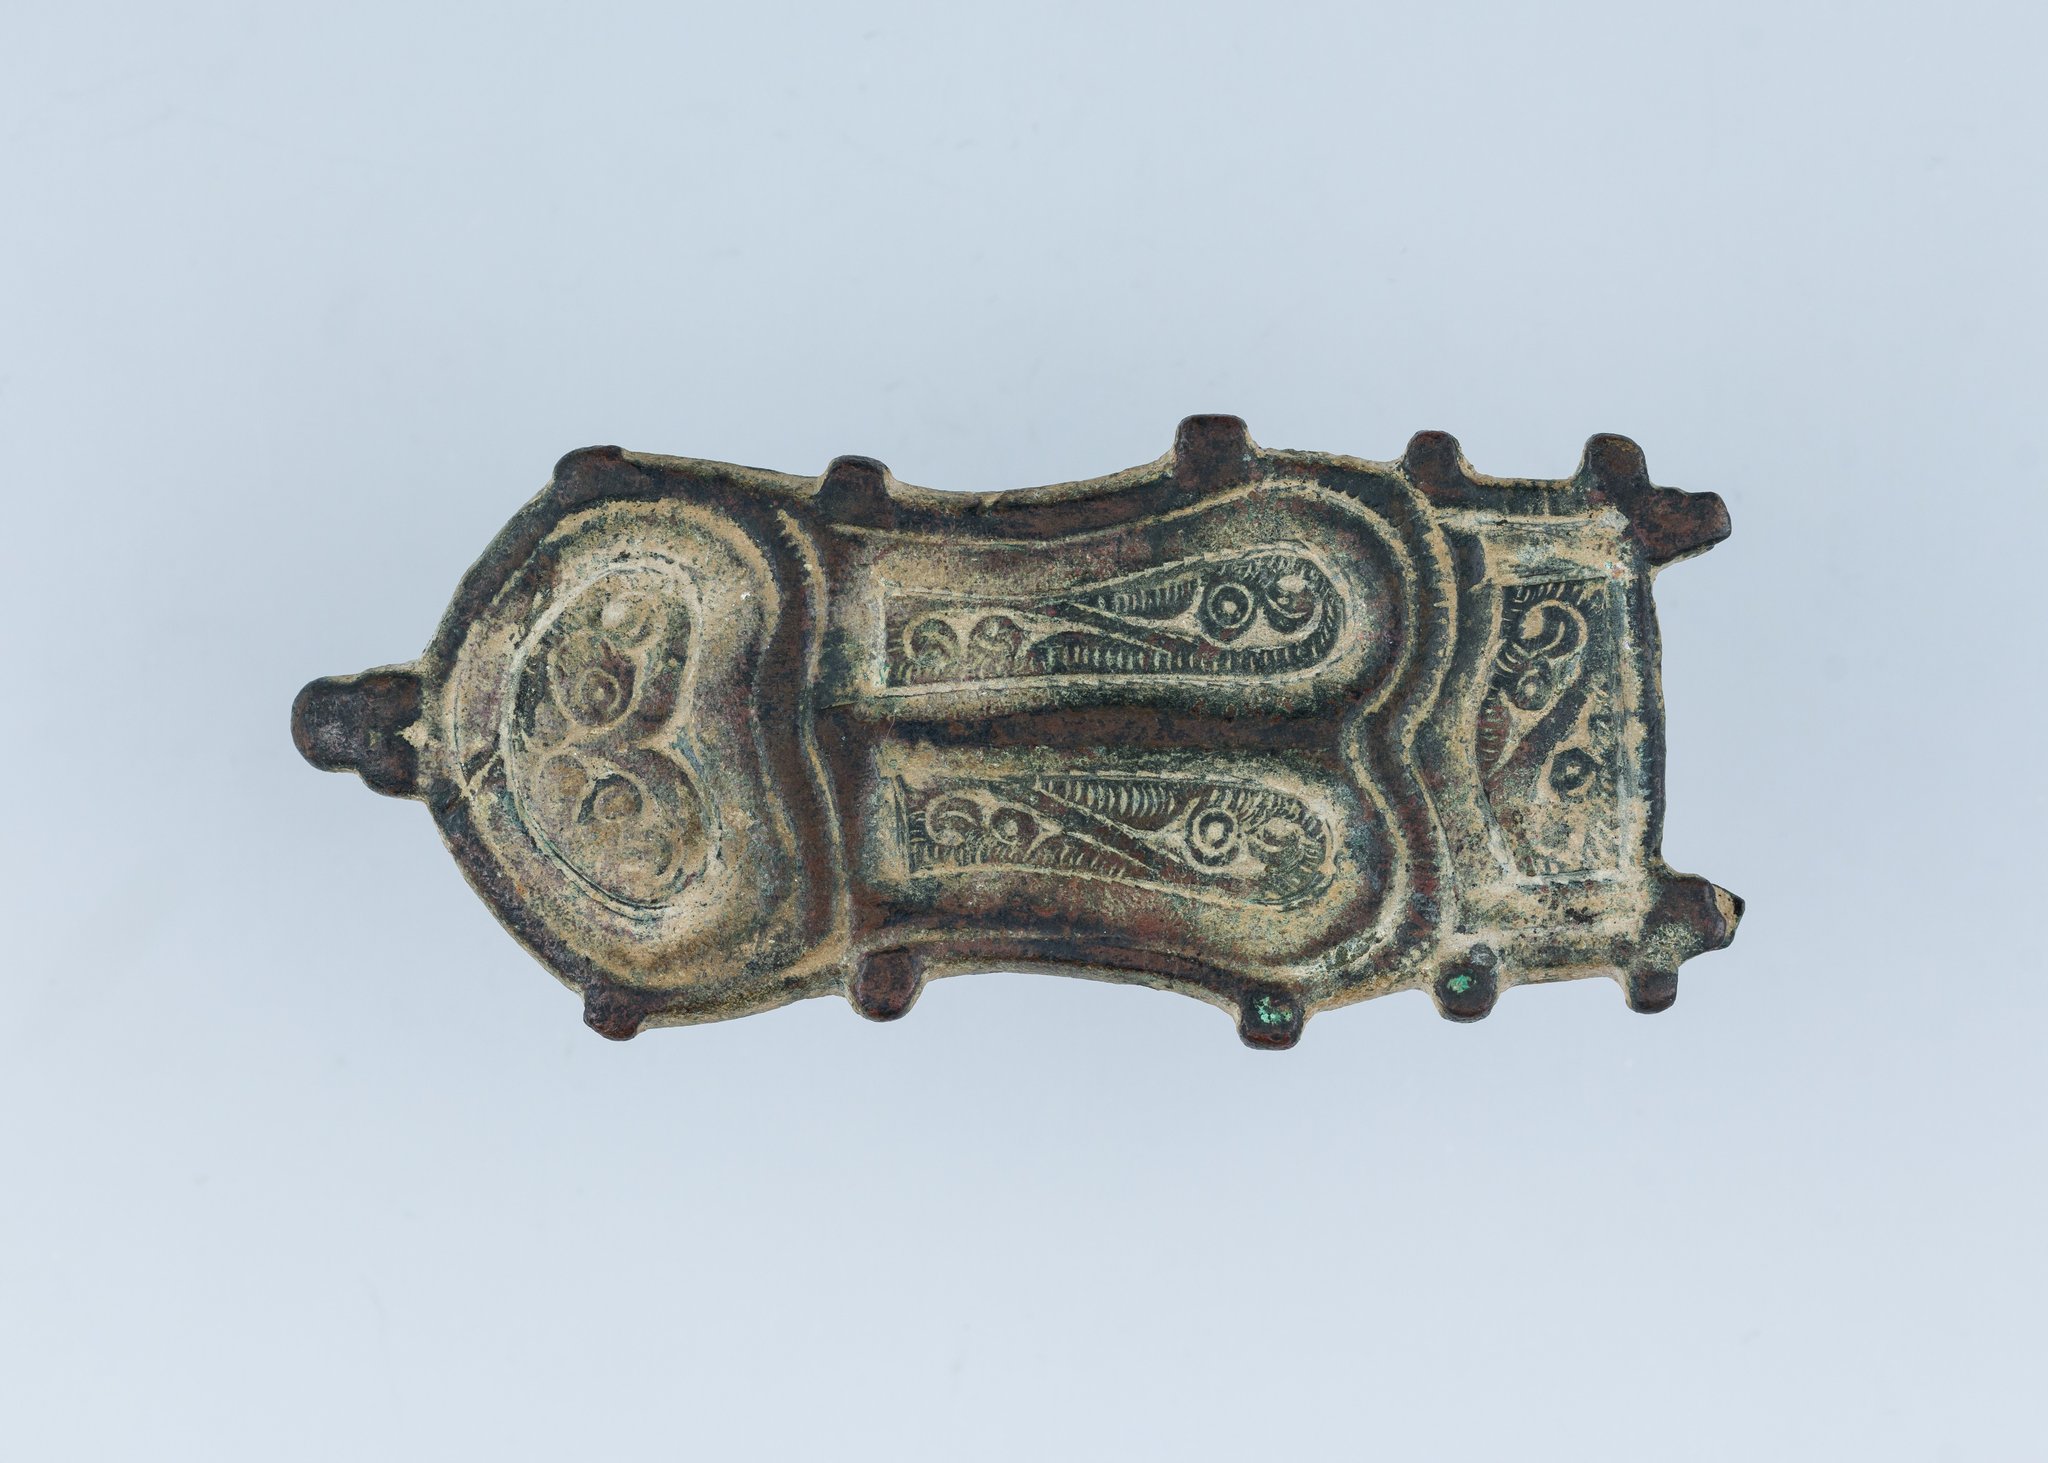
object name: buckle shank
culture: visigothic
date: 601-700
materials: copper alloy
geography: spain or portugal